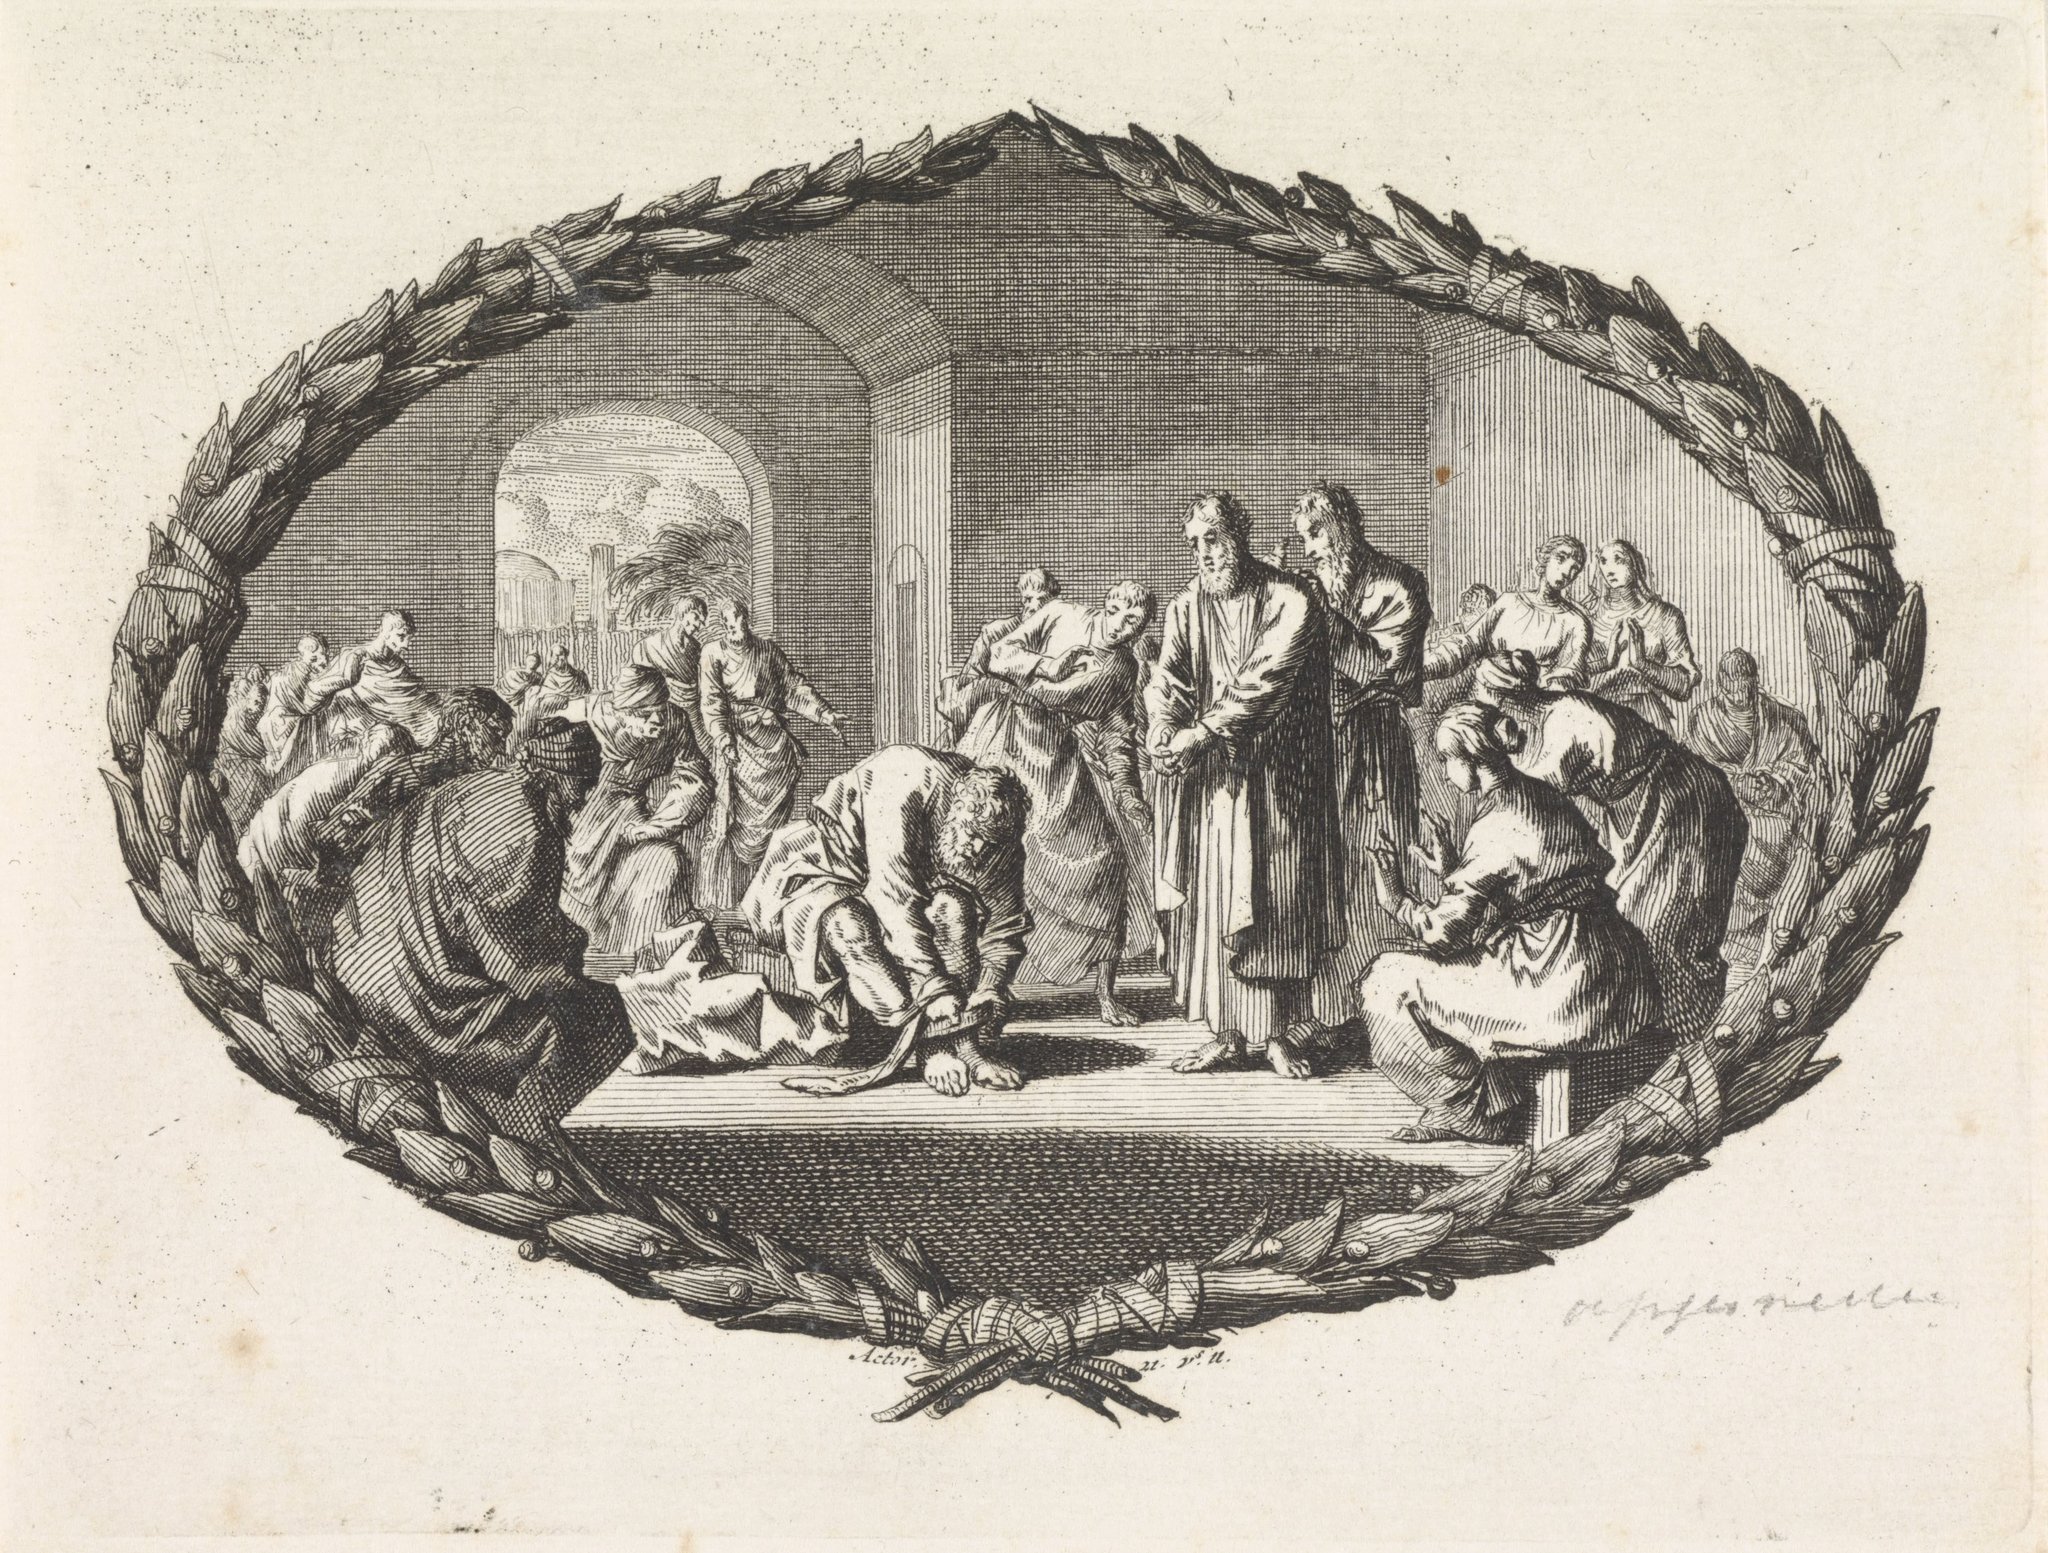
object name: print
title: Paulus ziet hoe Agabus zichzelf vastbindt aan zijn gordel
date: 1700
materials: paper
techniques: etching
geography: amsterdam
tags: ornament ~ cartouche, the arrest of paul in jerusalem is foretold by agabus, who binds his own hands and feet with paul's girdle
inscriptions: collector's mark: Lugt 2228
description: Een voorstelling in een cartouche van bladeren. De profeet Agabus bindt zijn handen en voeten vast aan de gordel van Paulus. Hij voorspelt aldus het lot van Paulus in Jeruzalem. Onder de cartouche de Bijbelreferentie Hand. 21:11.